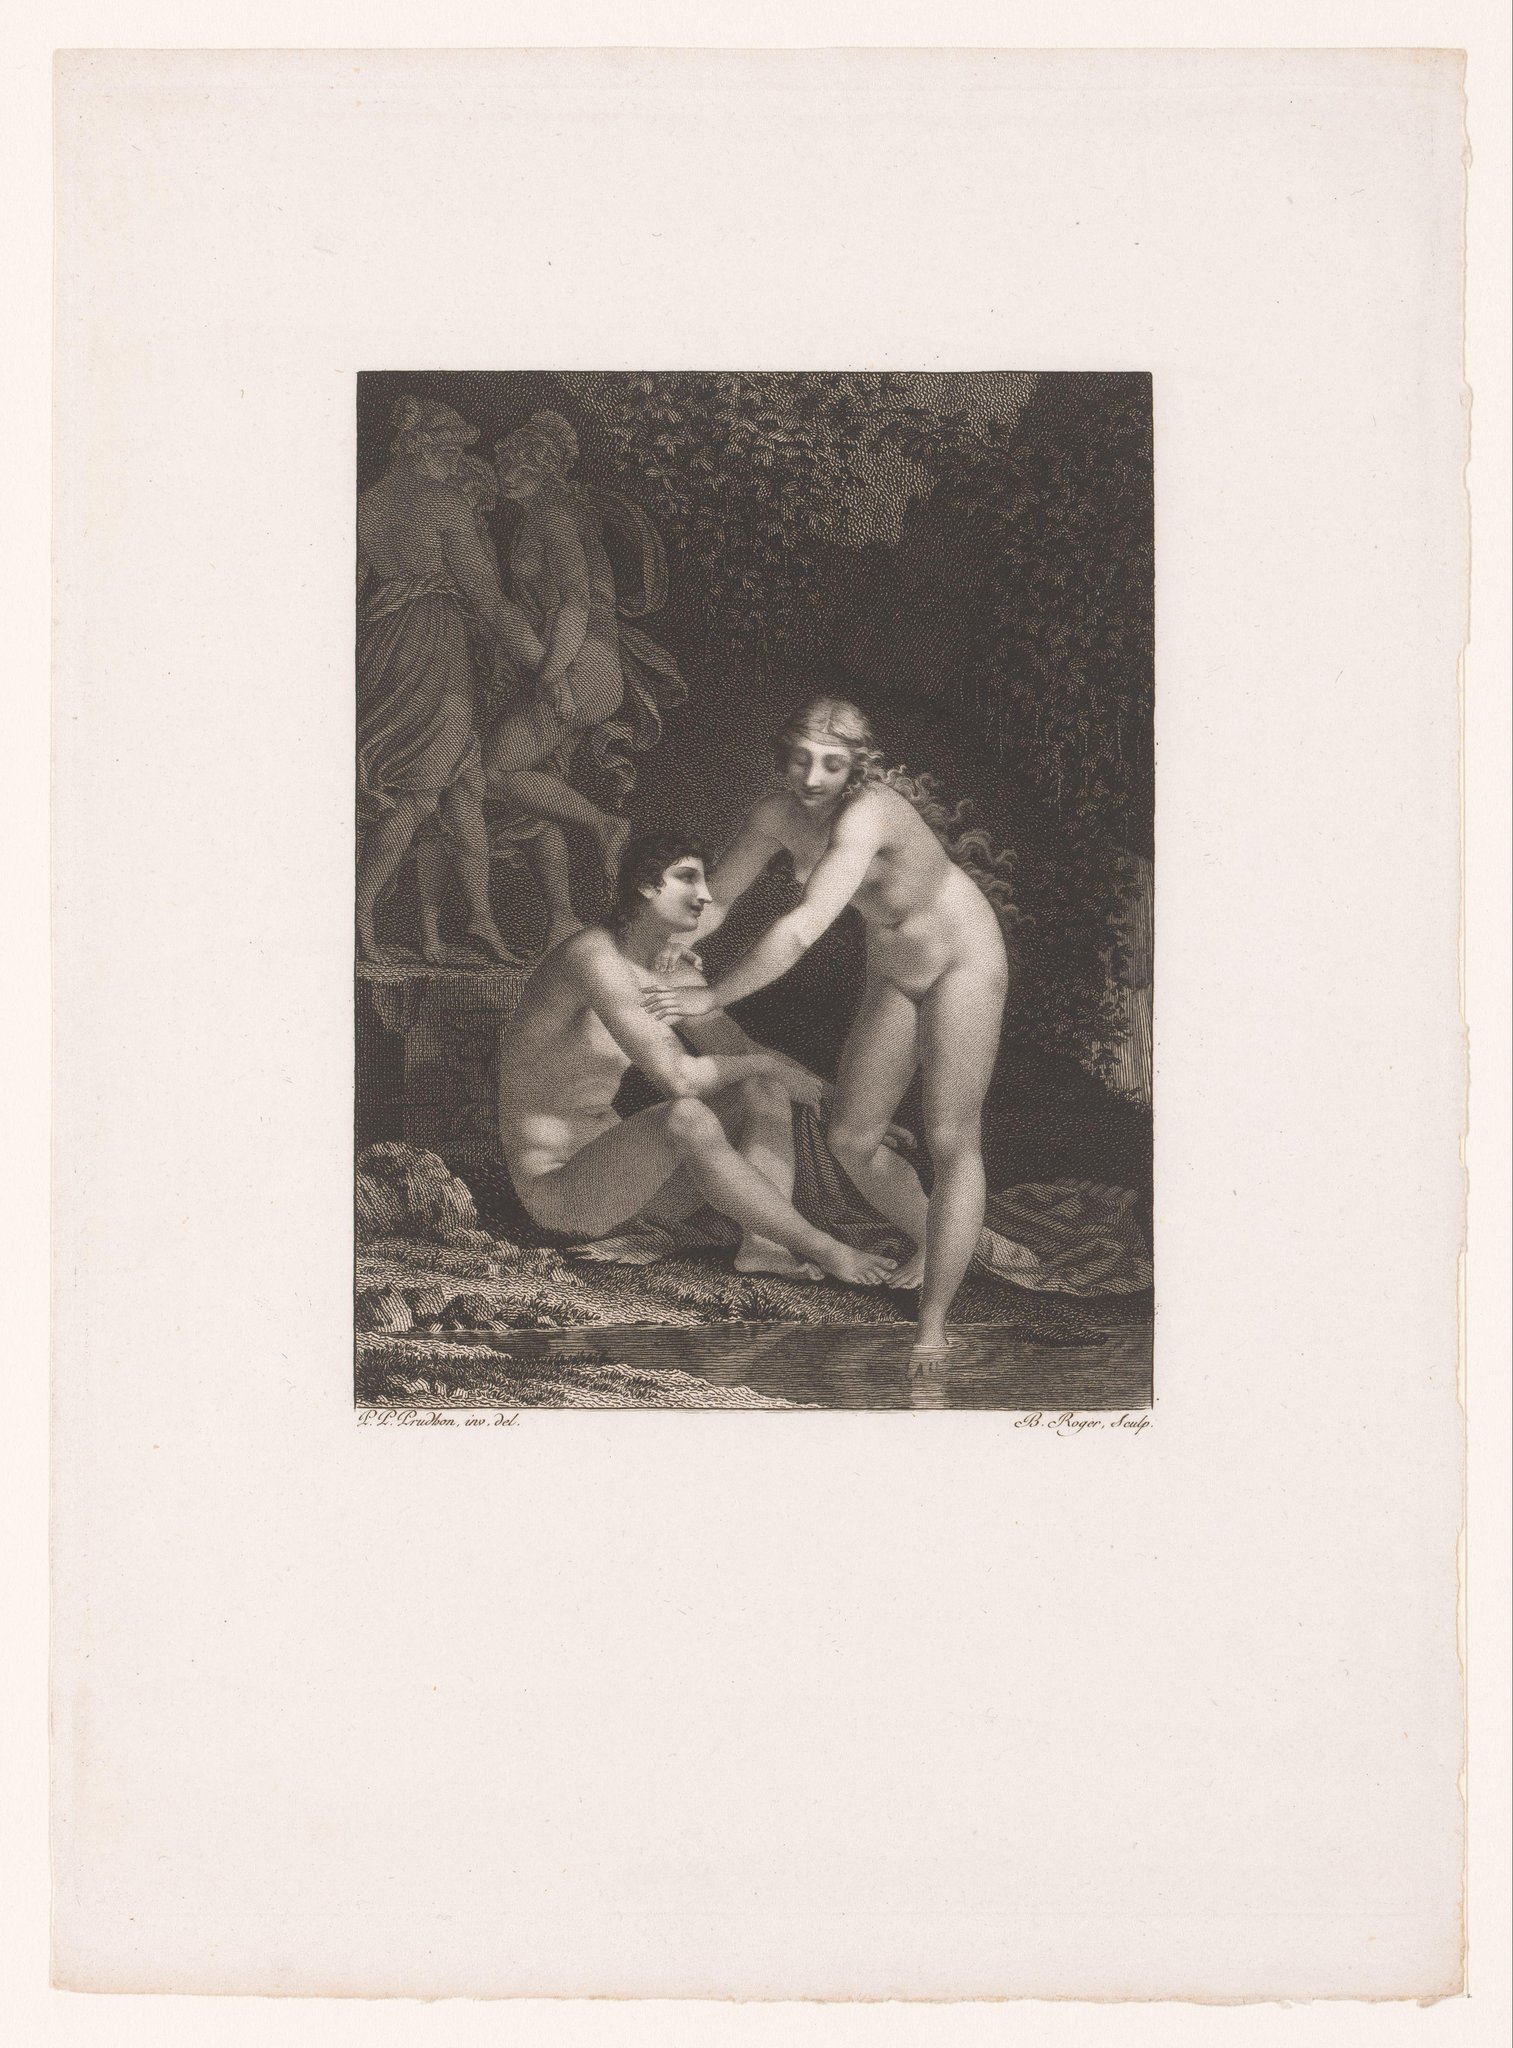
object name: print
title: Daphnis en Chloë badend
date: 1800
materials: paper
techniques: etching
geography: paris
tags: daphnis (in greek mythology a shepherd who invented pastoral poetry, chloe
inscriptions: collector's mark: Lugt 2228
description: Prent uit: Amyot, Jacques. Les Amours pastorales de Daphnis et de Chloé (...). Parijs: François-Ambroise Didot, 1800.